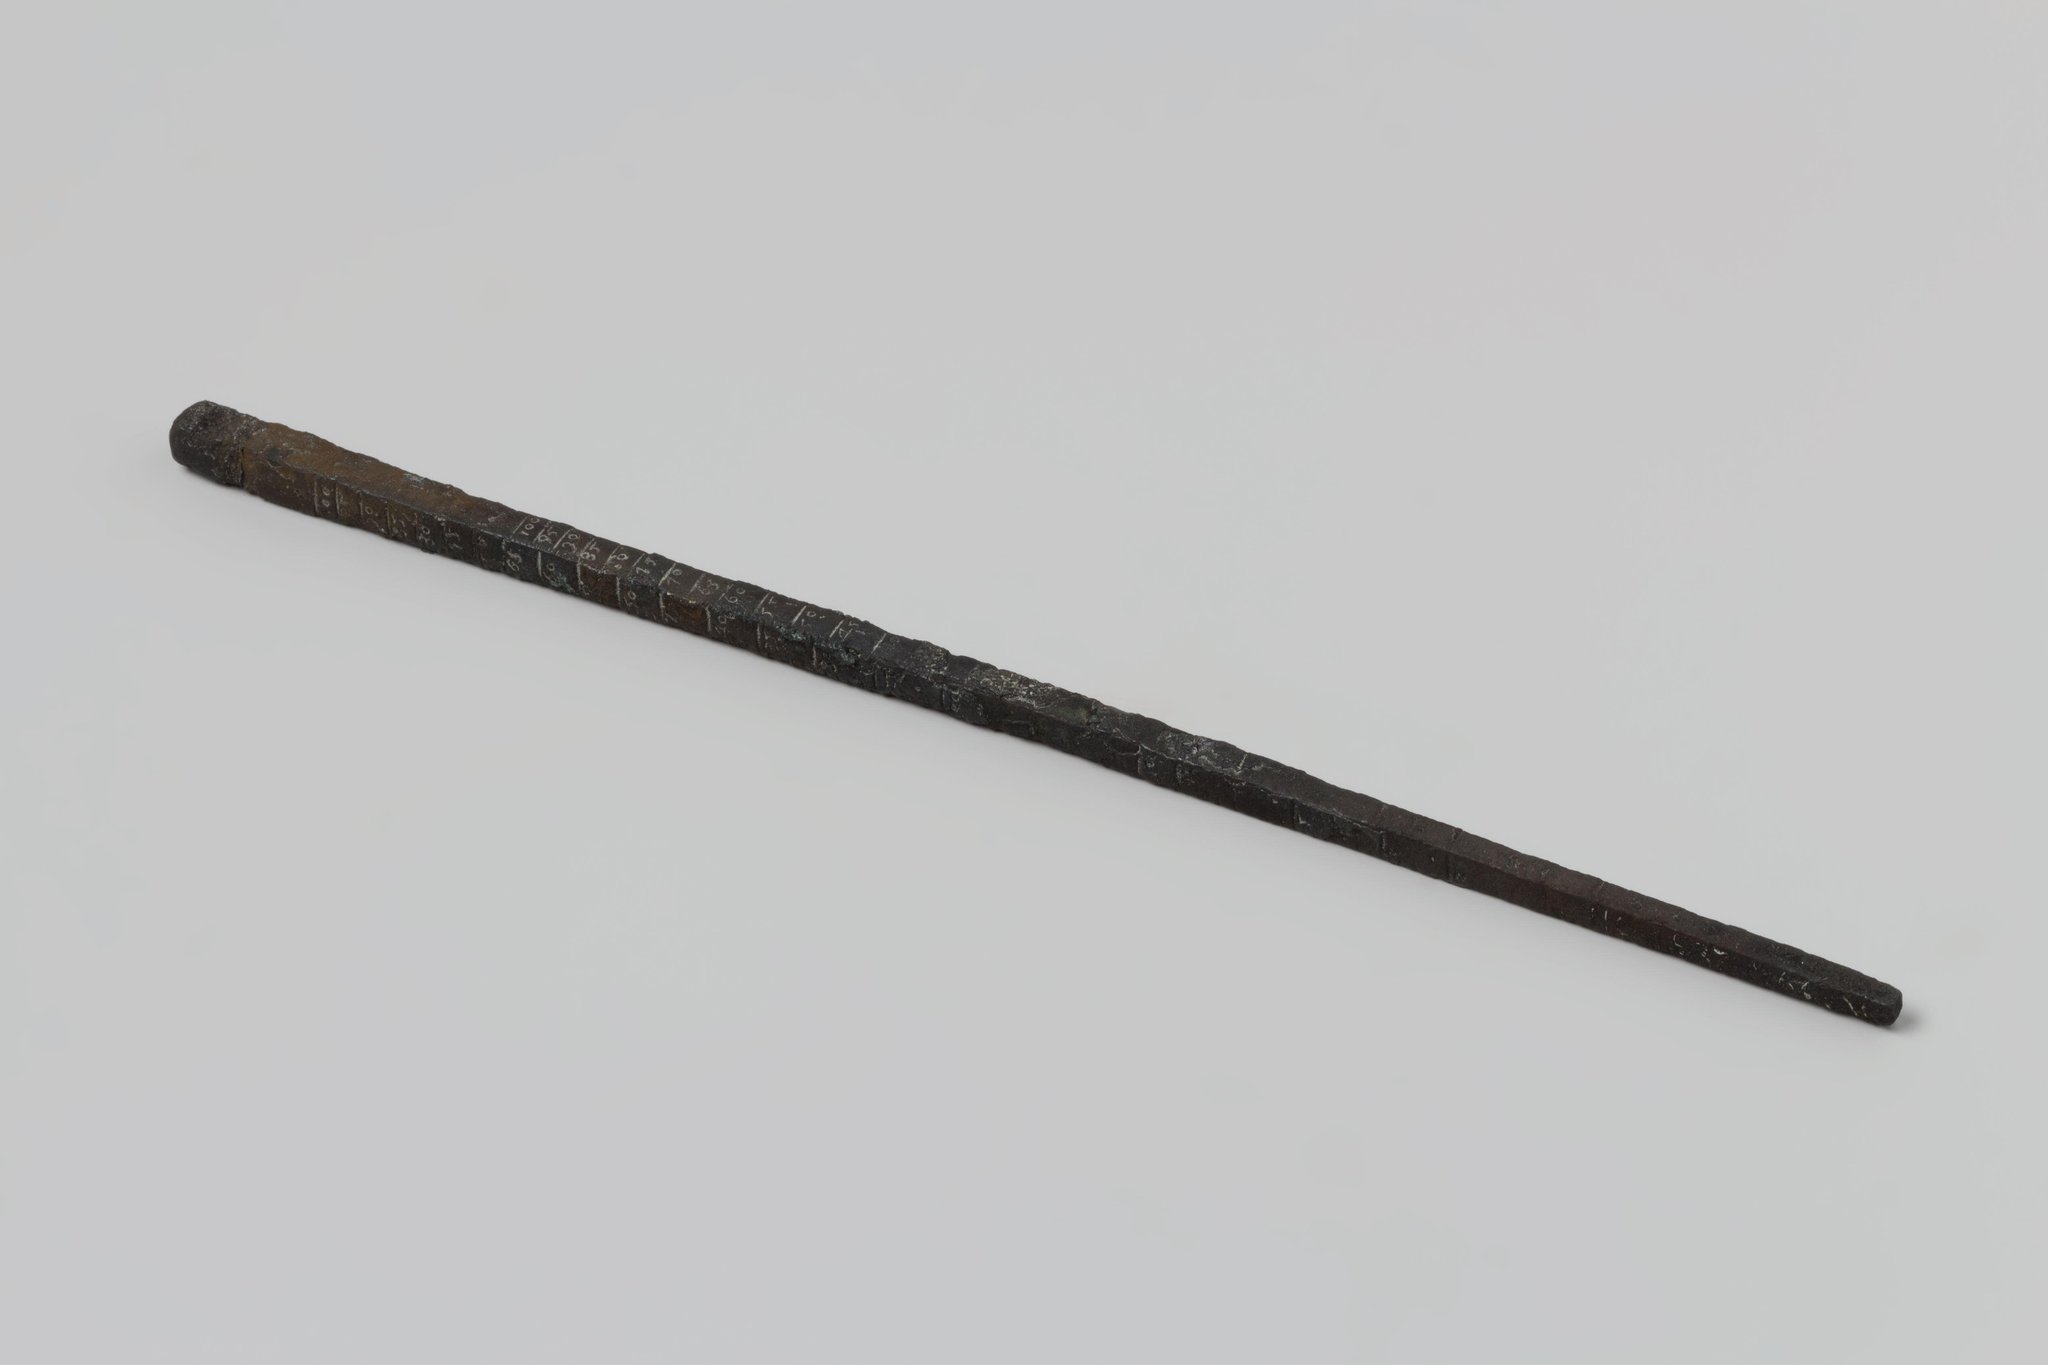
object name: measuring rod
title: Maatstok uit V.O.C.-schip de 'Witte Leeuw'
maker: Anonymous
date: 1613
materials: bronze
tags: verenigde oostindische compagnie, sint-helena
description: Maatstok uit V.O.C.-schip de 'Witte Leeuw'. Alle vier de zijden van de maatstok zijn op verschillende wijzen verdeeld in strepen met cijfers. De maatstok werd gebruikt door de constapel om de benodigde kruitlading te berekenen.